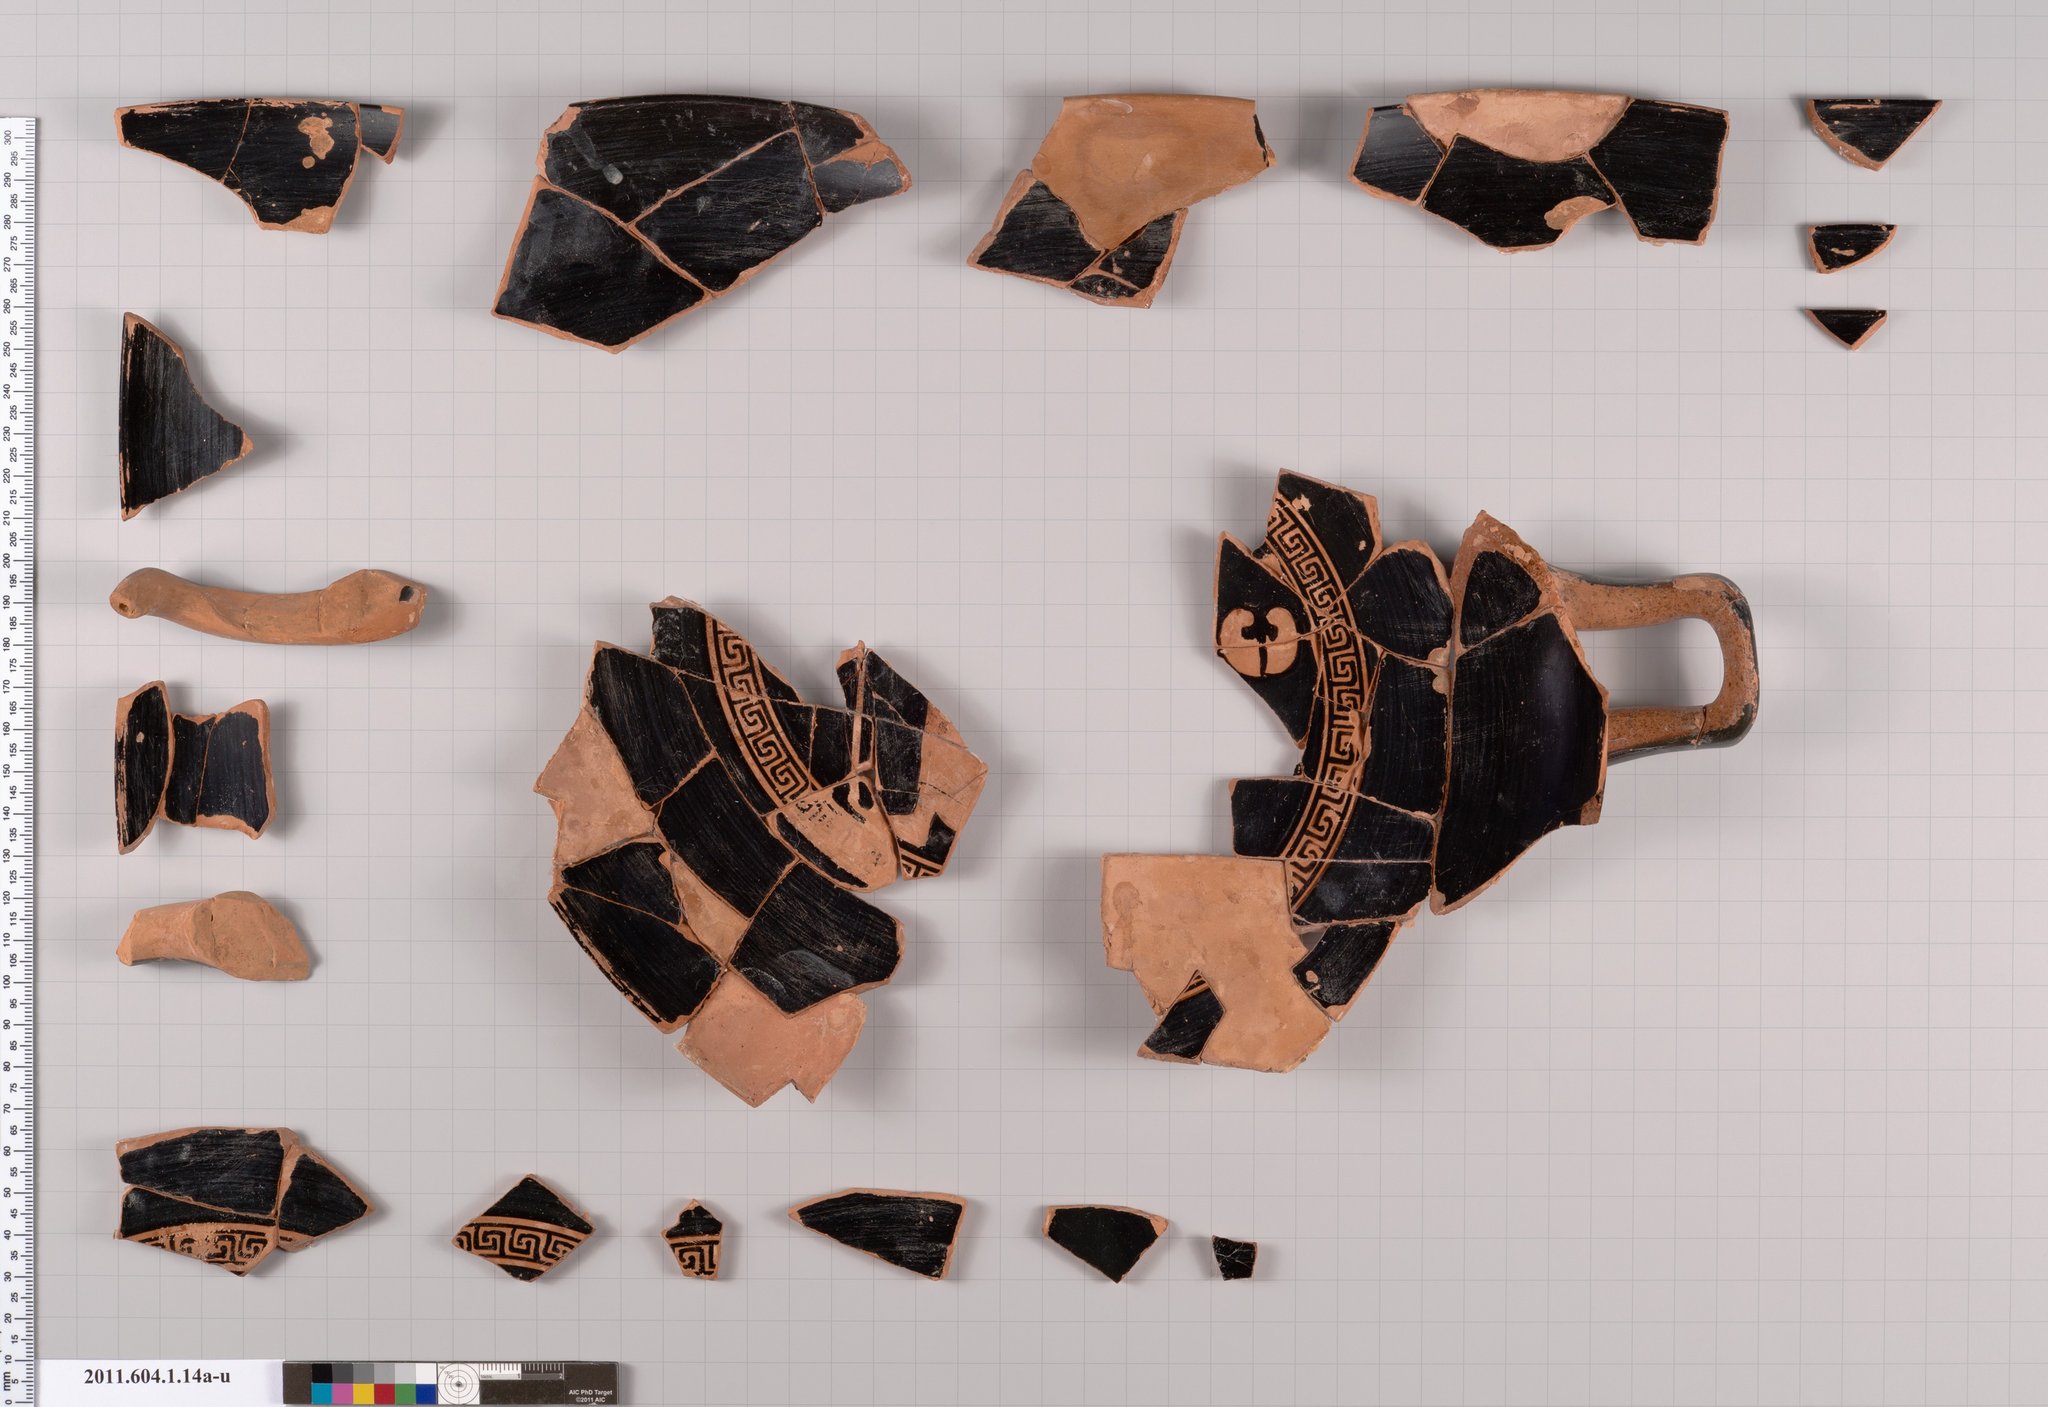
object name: kylix fragment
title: Terracotta fragments of a kylix (drinking cup)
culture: greek, attic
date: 480-470 BCE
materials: terracotta